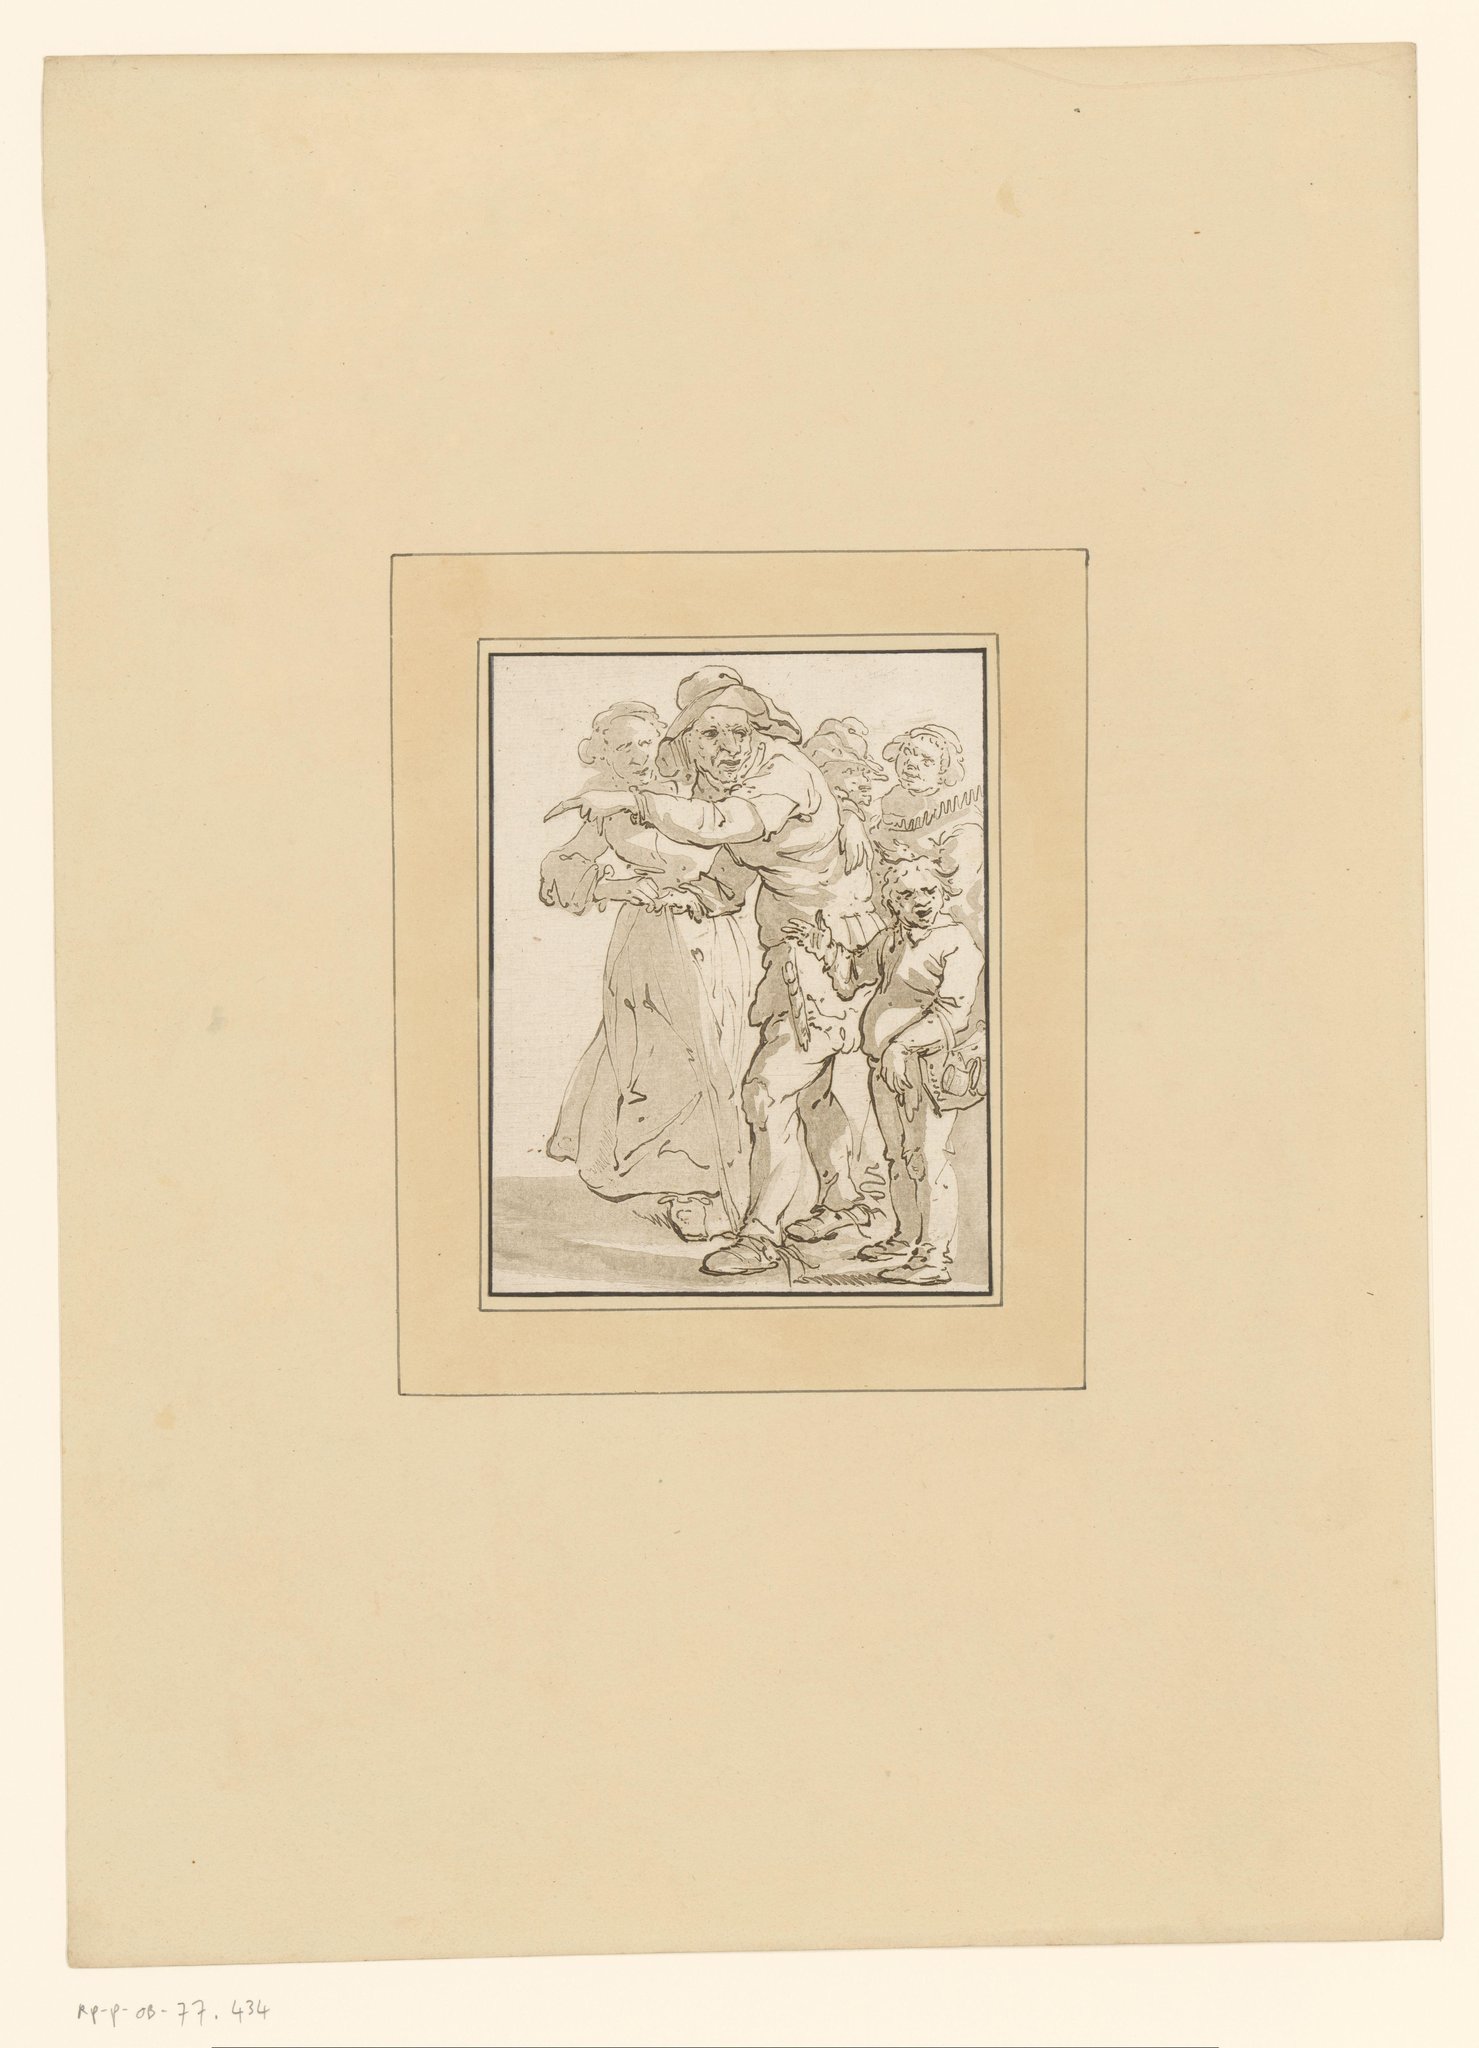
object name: print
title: Oude boer tenmidden van kermisvierders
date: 1780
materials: paper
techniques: aquatint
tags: performance in the open air (pleasure fair)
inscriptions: collector's mark: Lugt 2228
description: Nummer 8 uit het prentenalbum 'Dessins des meilleurs Peintres d'Italie, d'Allemagne, et des Pays-Bas, Tirés de divers célebres Cabinets. Gravés d'apres les Originaux de même grandeur par Jean Théophile Prestel'. Neurenberg: J.G. Prestel, 1783.